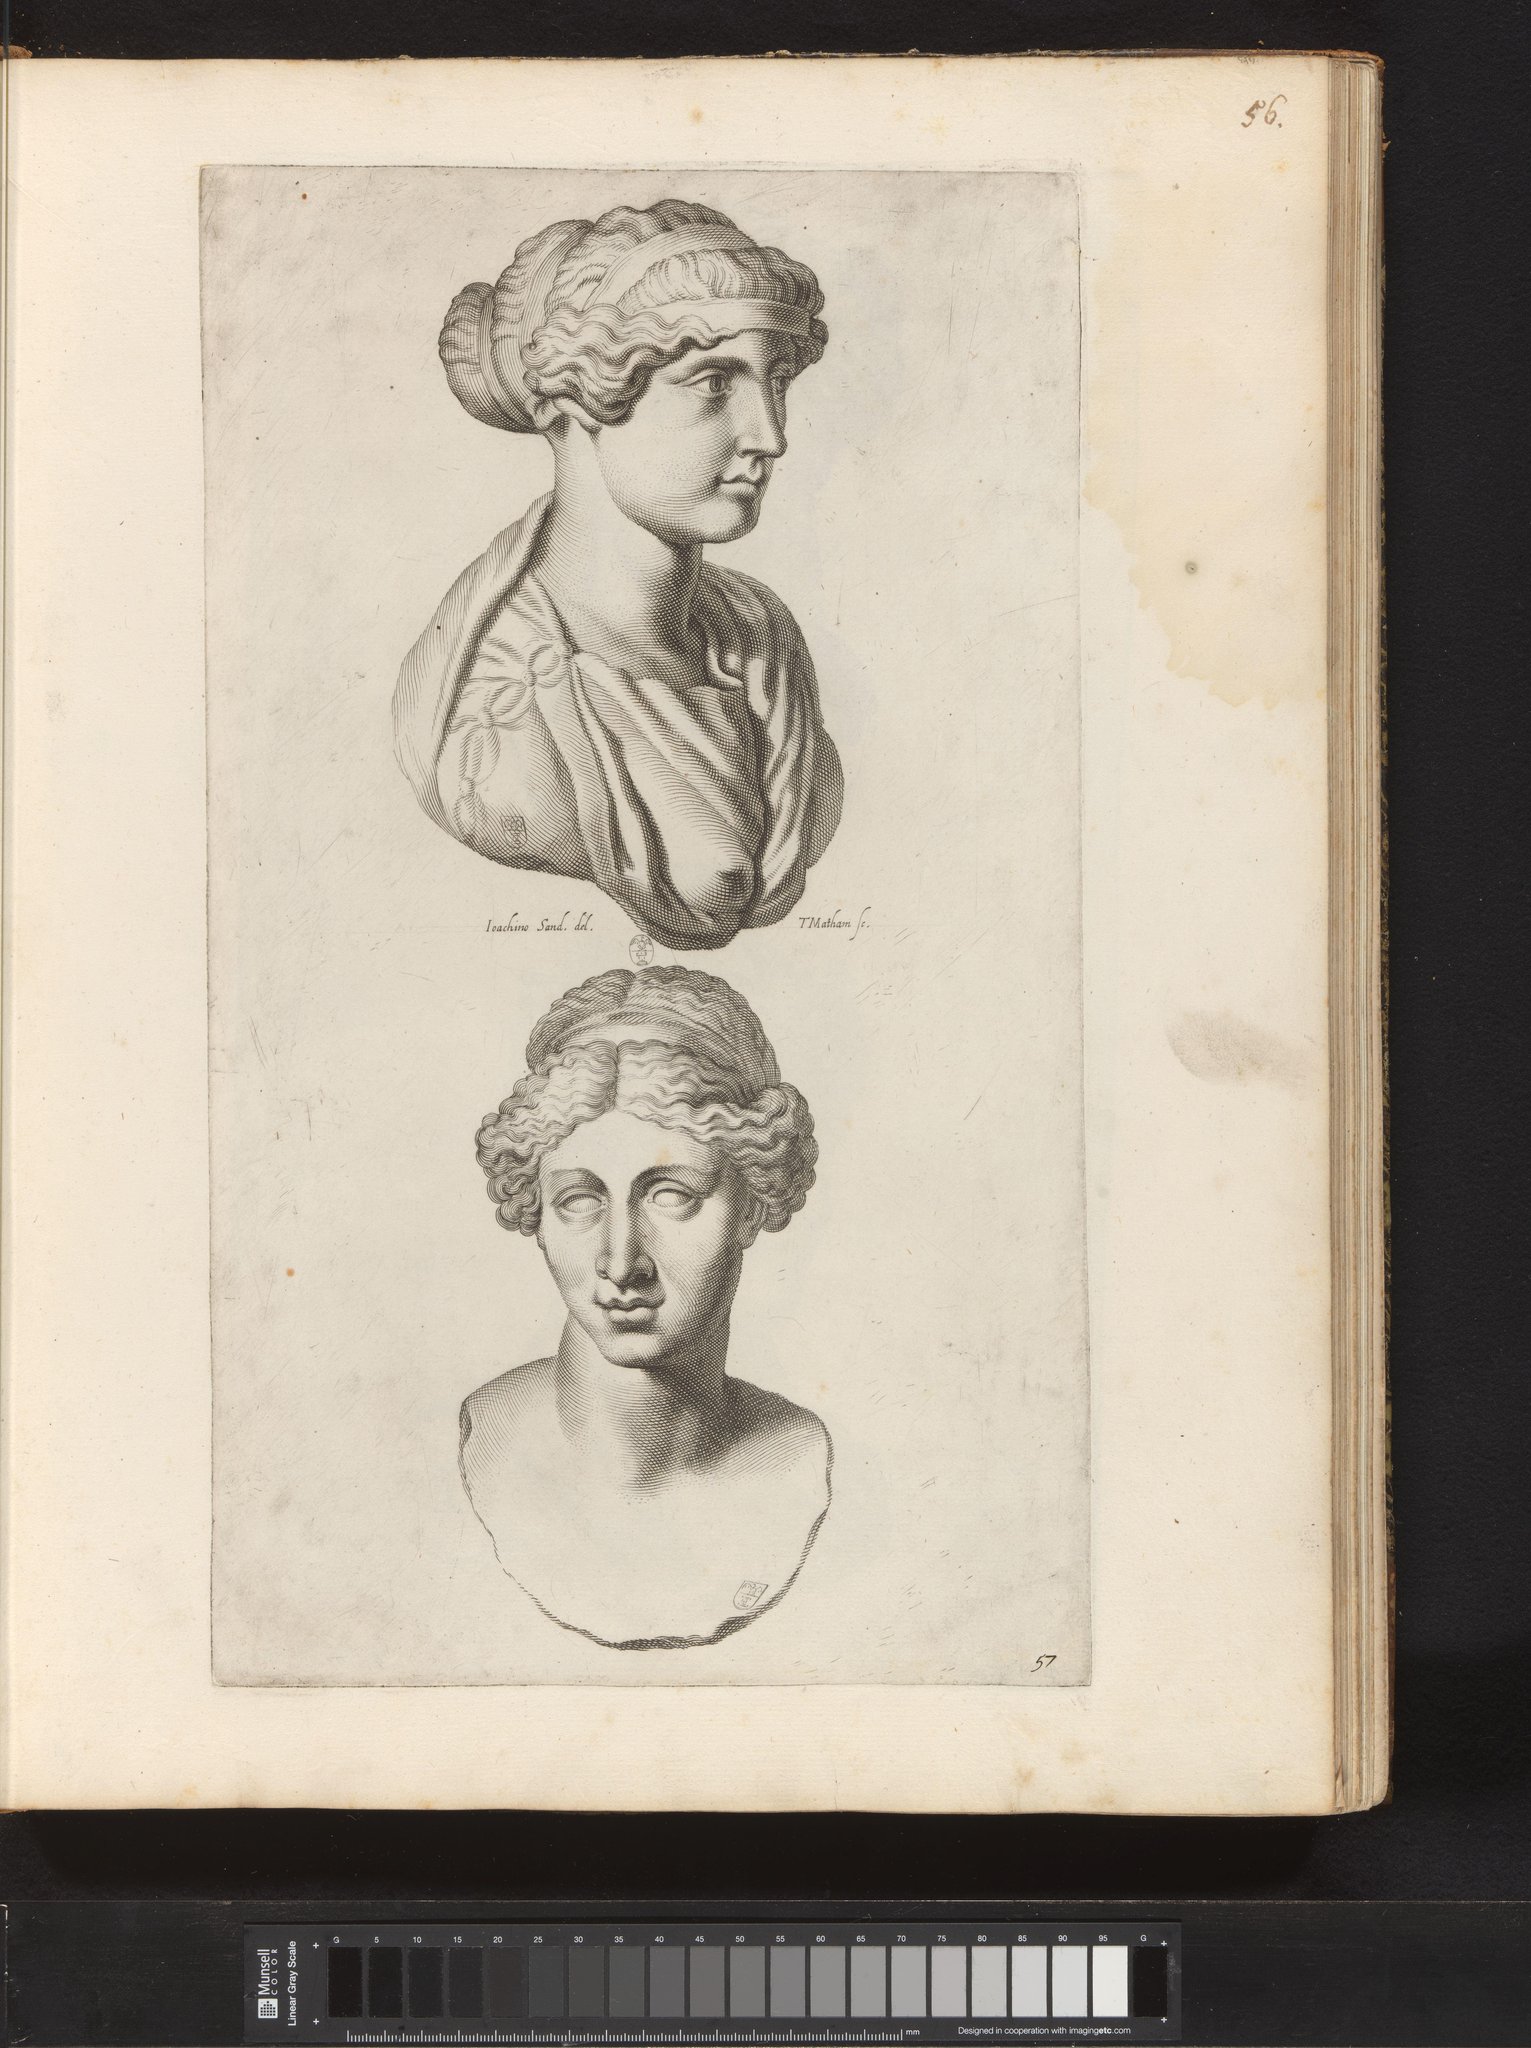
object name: album leaf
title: Galleria Giustiniana del Marchese Vincenzo Giustiniani II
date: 1636-1647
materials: paper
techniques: engraving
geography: rome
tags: rome, piece of sculpture, reproduction of a piece of sculpture, female persons from classical history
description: Twee Romeinse portretbustes van Antonia Minor en een onbekende vrouw. Onder de bovenste buste het wapenschild van Vincenzo Giustiniani. Prent maakt deel uit van een album met een serie prenten naar de sculpturen in de verzameling in de Galleria Giustiniani te Rome.